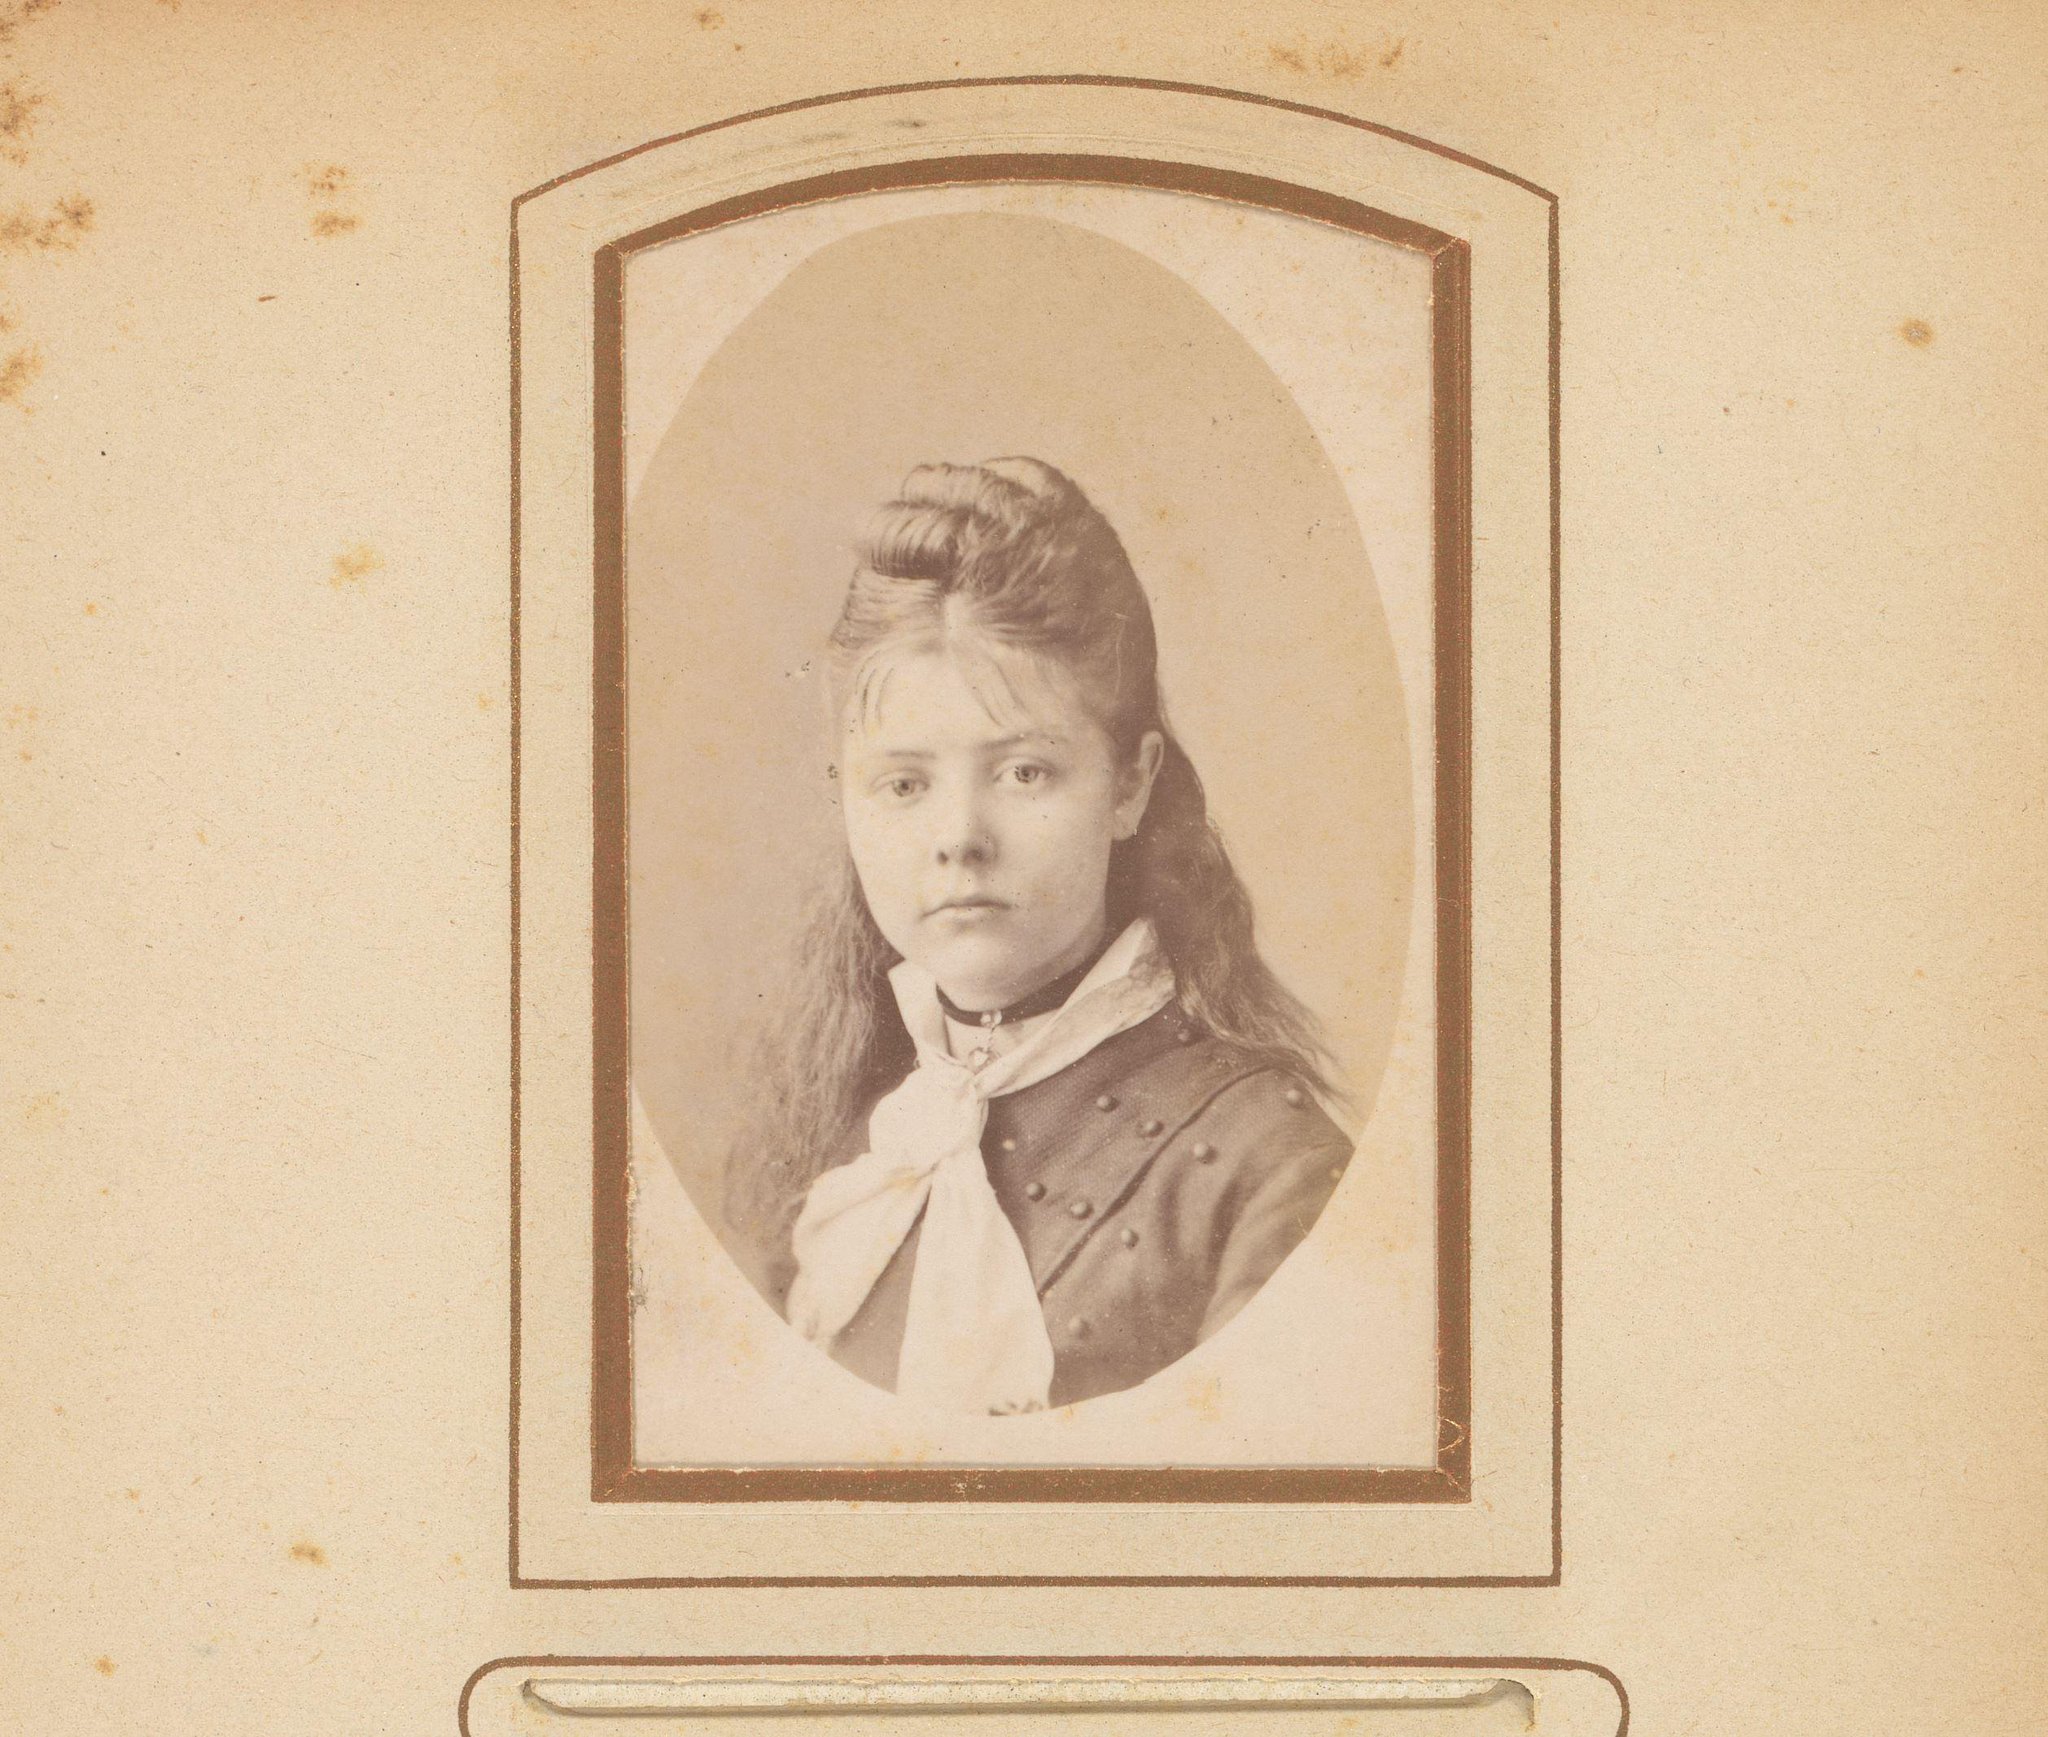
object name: album leaf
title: Portret van een meisje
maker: bernardus bruining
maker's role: fotograaf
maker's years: 1834-1900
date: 1860-1900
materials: cardboard, photographic support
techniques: albumen print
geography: leiden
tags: historical persons - bb - woman, girl (child between toddler and youth)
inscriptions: inscription: ‘B. Bruining/ Leiden’, annotation: ‘AV’